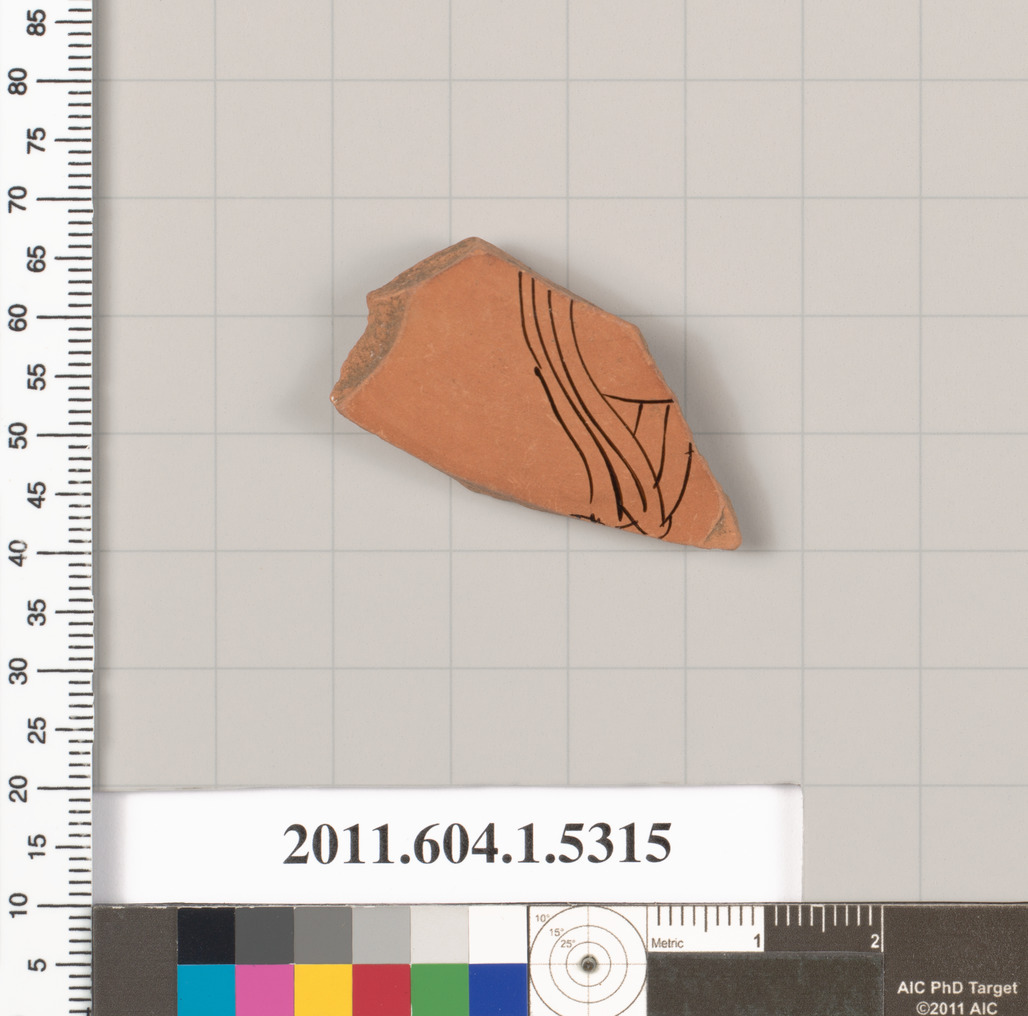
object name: kylix fragment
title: Terracotta fragment of a kylix (drinking cup)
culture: greek, attic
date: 500-480 BCE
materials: terracotta